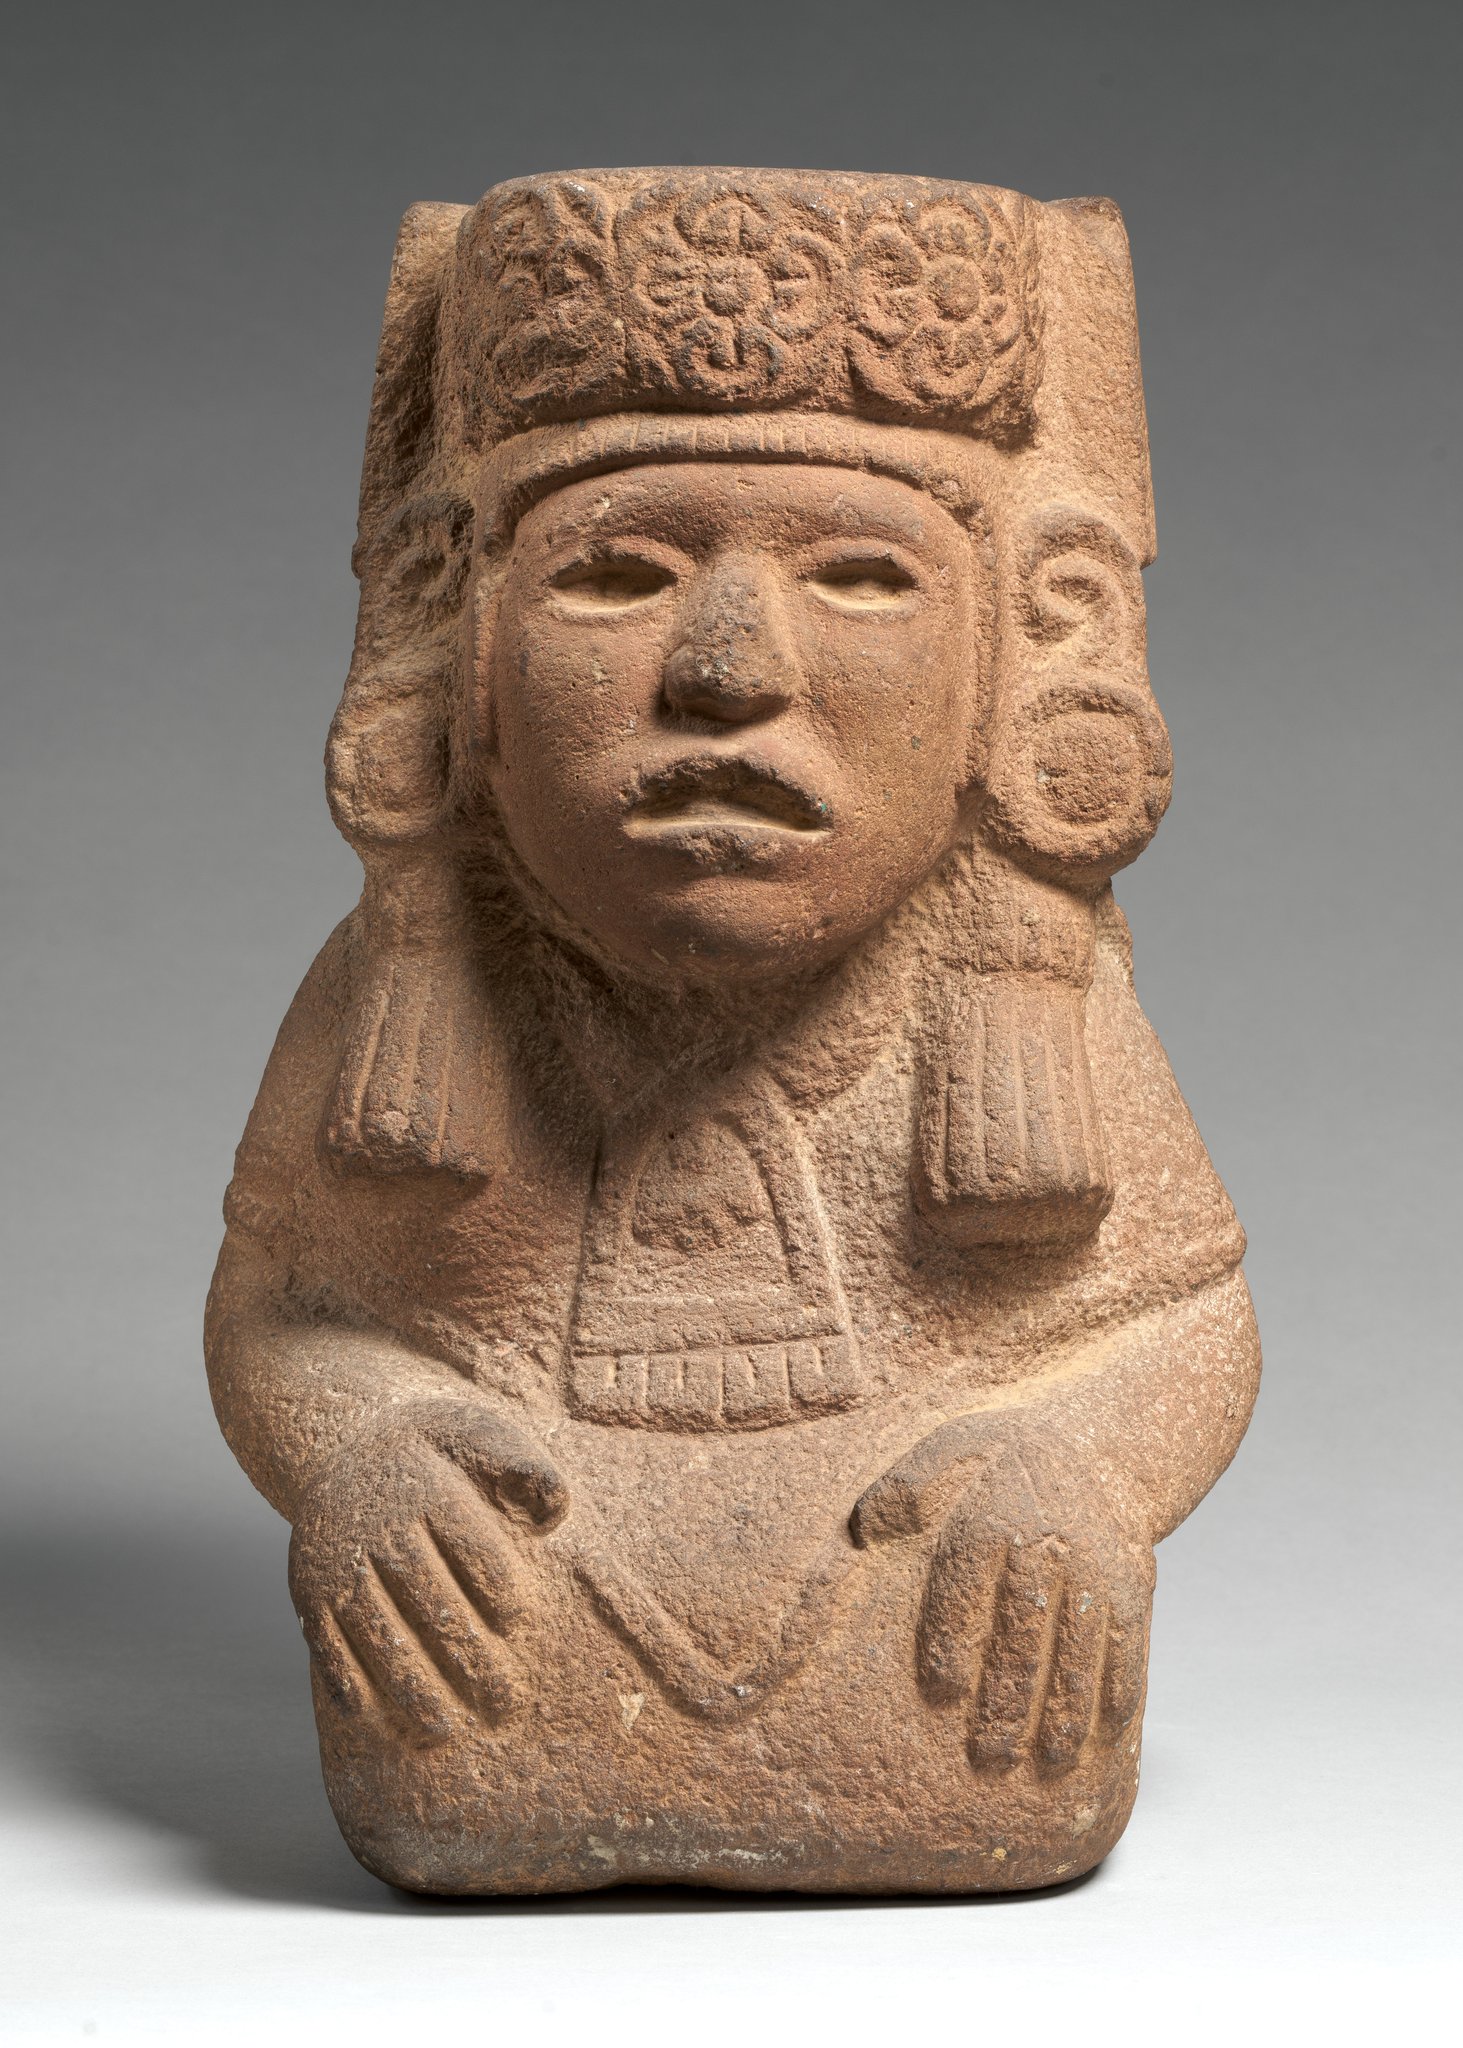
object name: female figure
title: Fertility goddess with floral band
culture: mexica, aztec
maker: mexica artist(s)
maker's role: artist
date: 1325-1521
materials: stone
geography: mexico